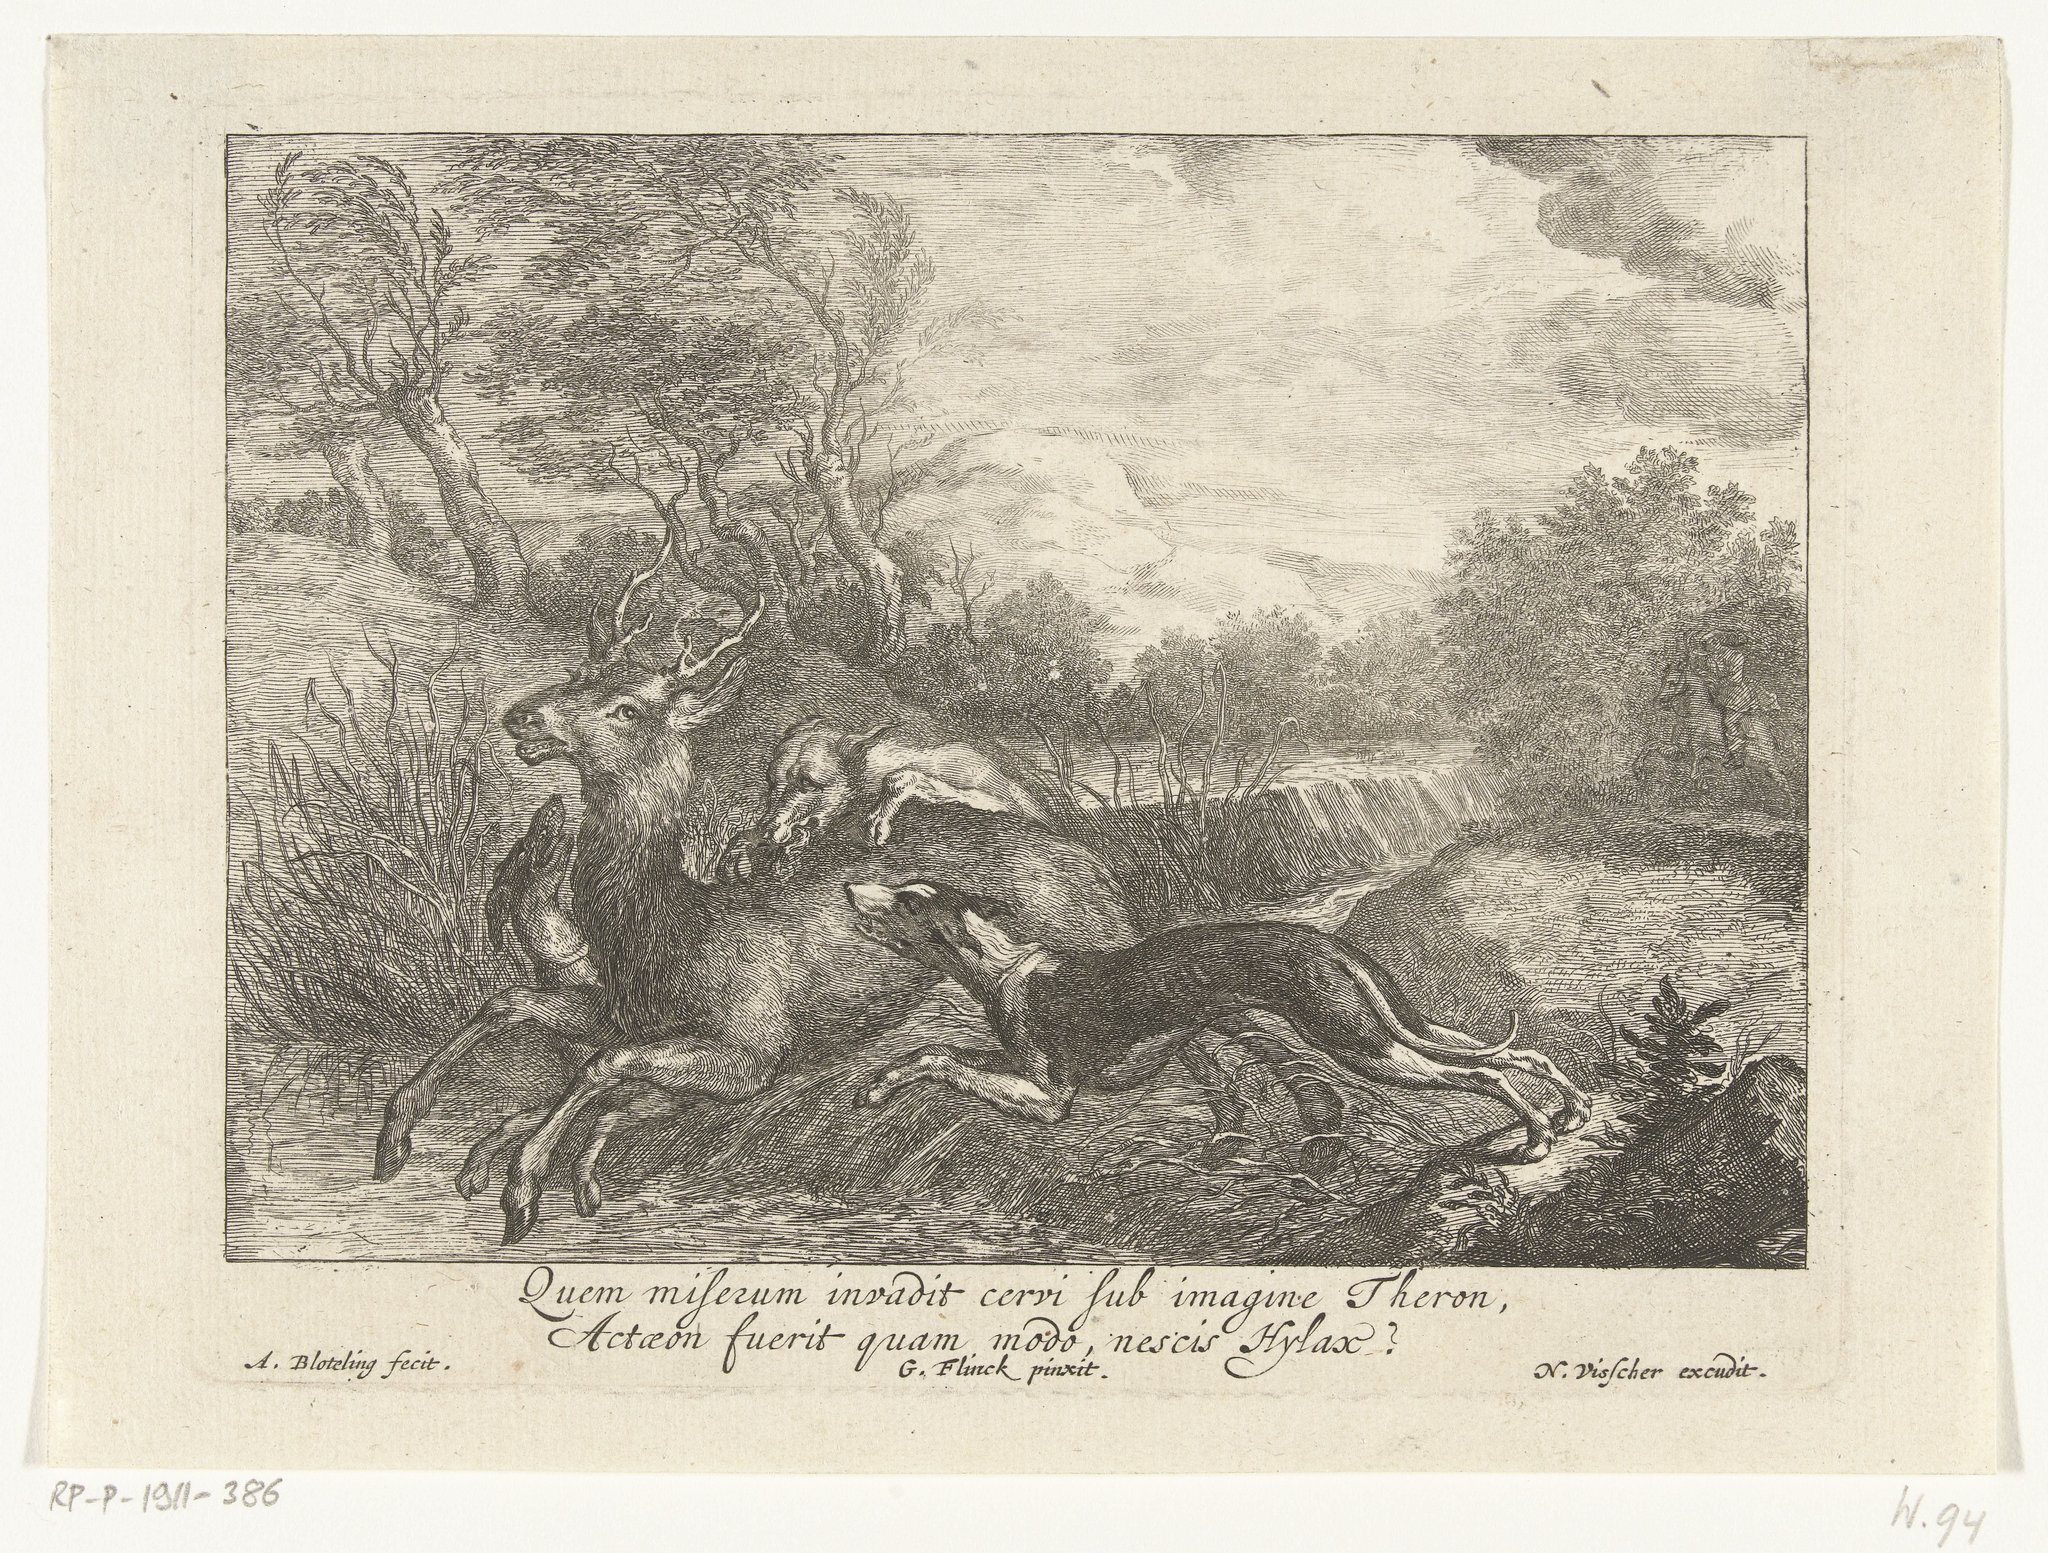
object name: print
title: Kleine hertenjacht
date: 1655-1690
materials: paper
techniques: etching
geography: amsterdam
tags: stag-hunting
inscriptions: collector's mark: Lugt 2228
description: Een hert wordt door drie jachthonden aangevallen. Onder de voorstelling een Latijns vers.